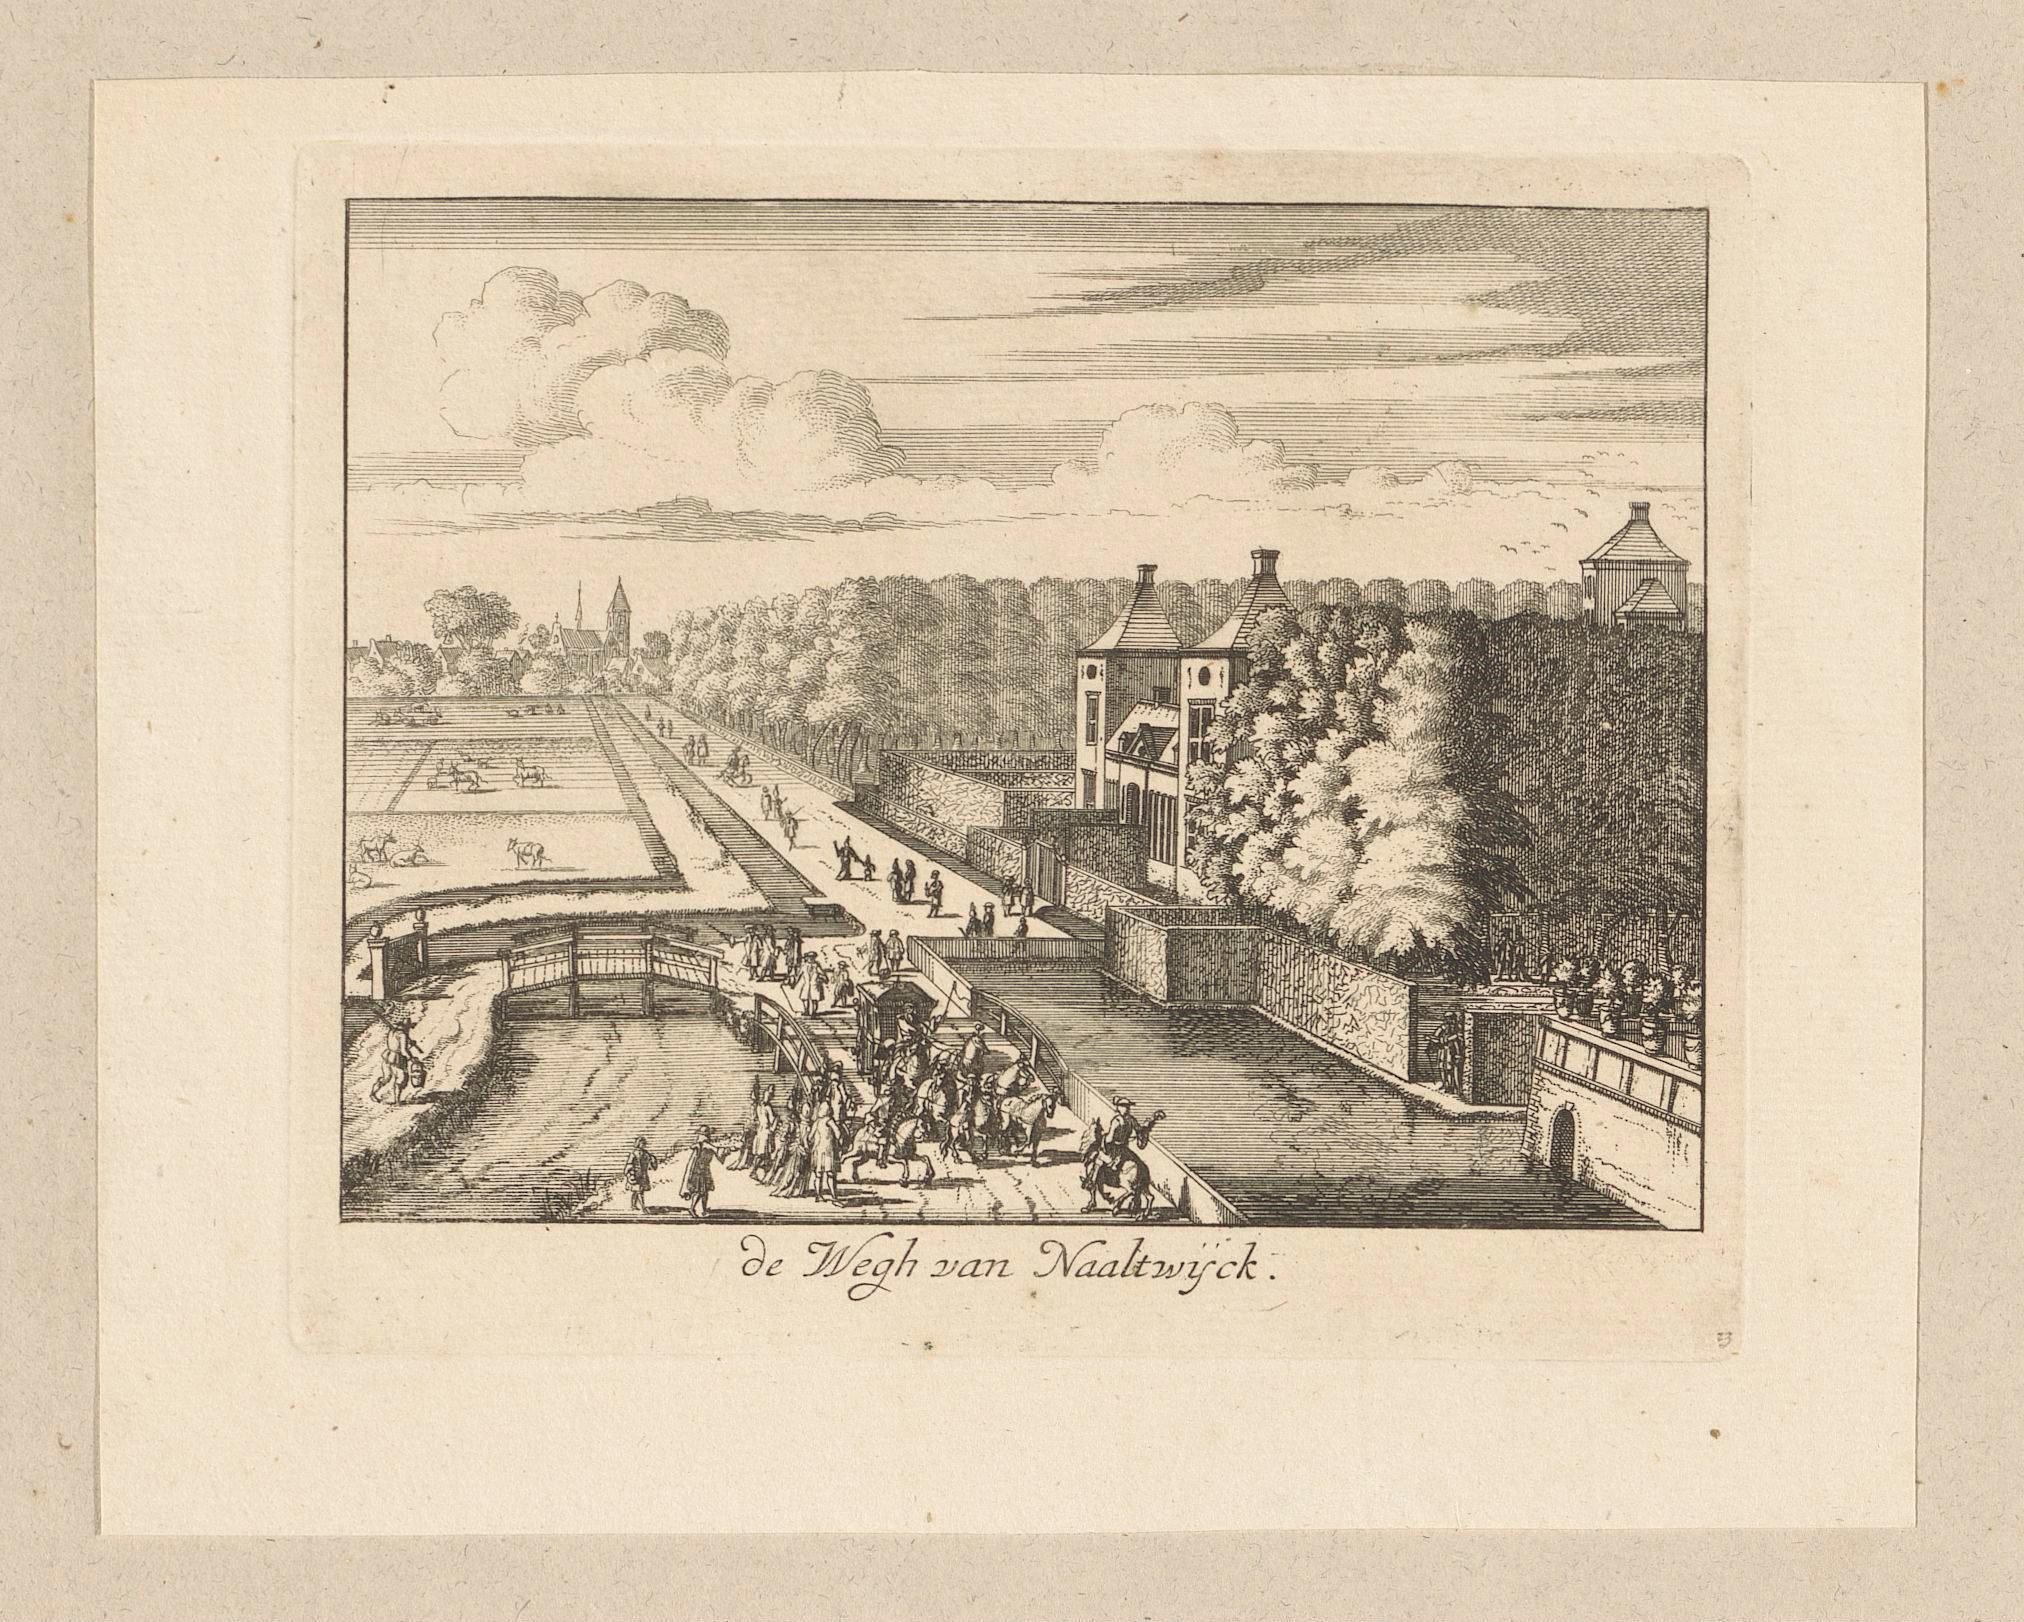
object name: print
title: Weg tussen Honselaarsdijk en Naaldwijk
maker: cornelis danckerts (ii)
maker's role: print maker, publisher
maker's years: 1664-1717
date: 1696-1717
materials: paper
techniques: etching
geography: amsterdam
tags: church (exterior), road, path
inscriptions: collector's mark: Lugt 2233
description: Weg langs een sloot met wandelaars, ruiters en rijtuigen. Rechts een bos, links weilanden met koeien, op de achtergrond de kerk van Naaldwijk. Rechtsonder genummerd: 13. Prent uit een serie van zestien prenten van Paleis Honselaarsdijk.